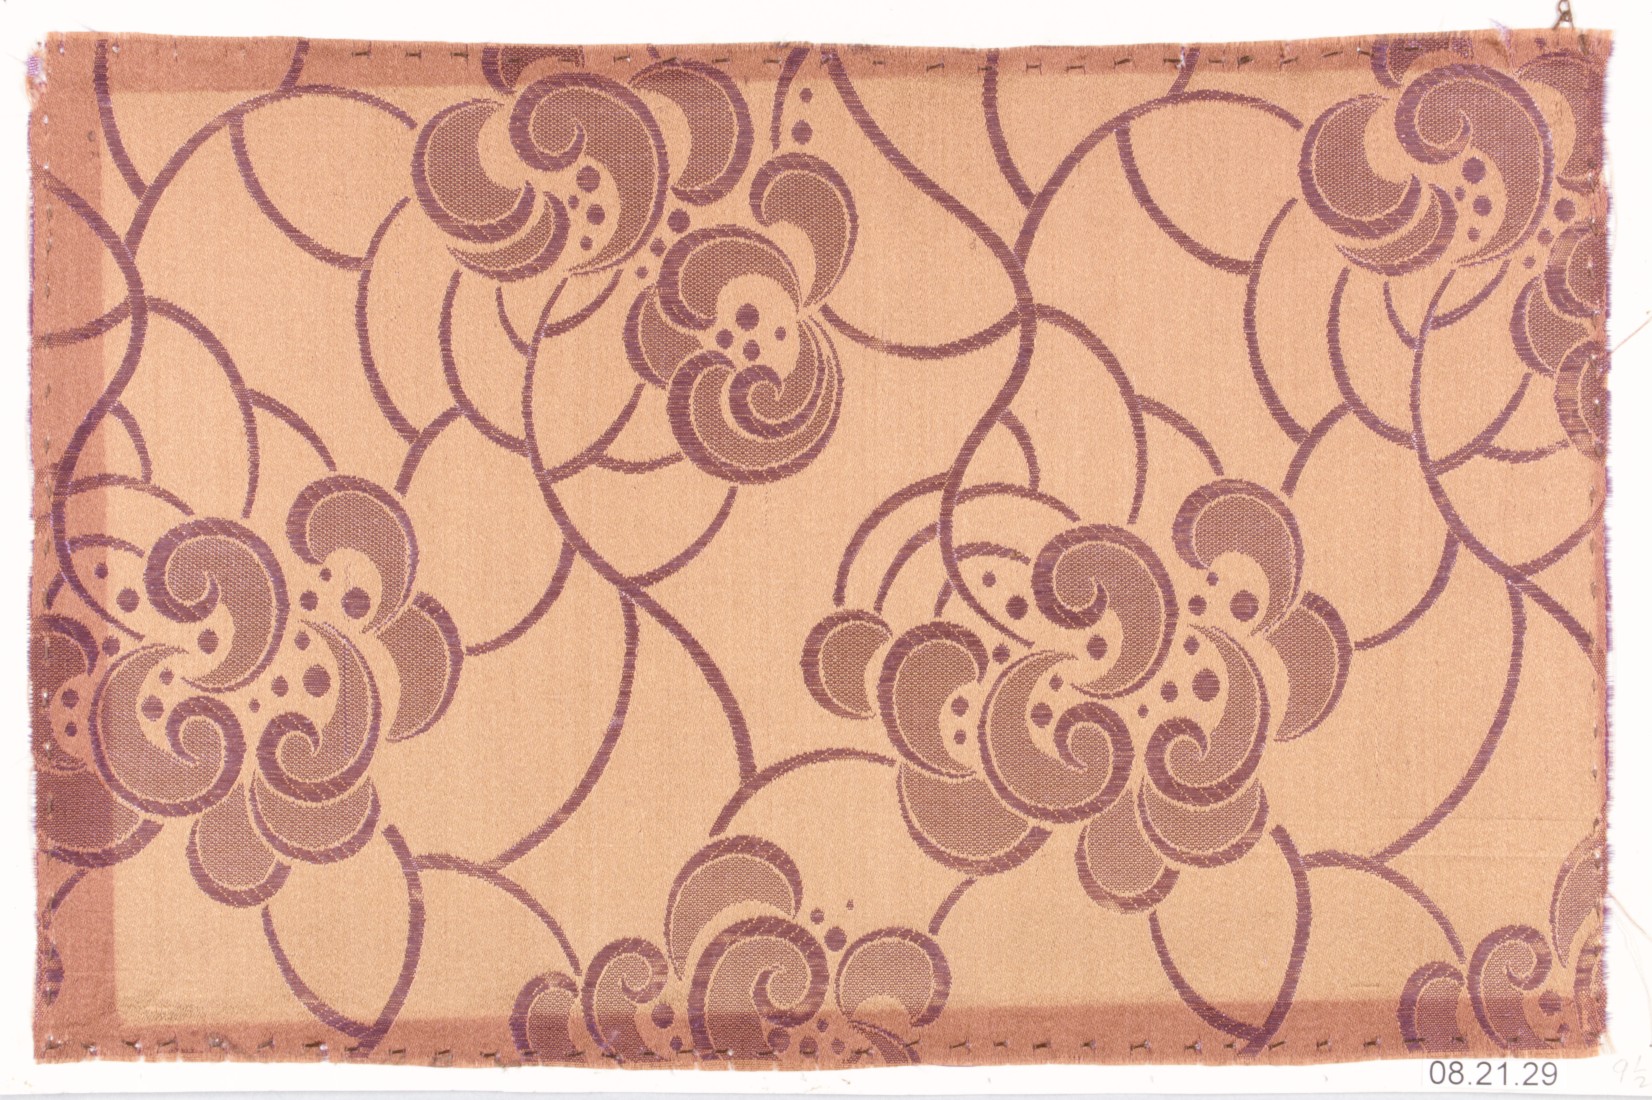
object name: textile sample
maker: Anonymous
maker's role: designer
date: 1900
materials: silk